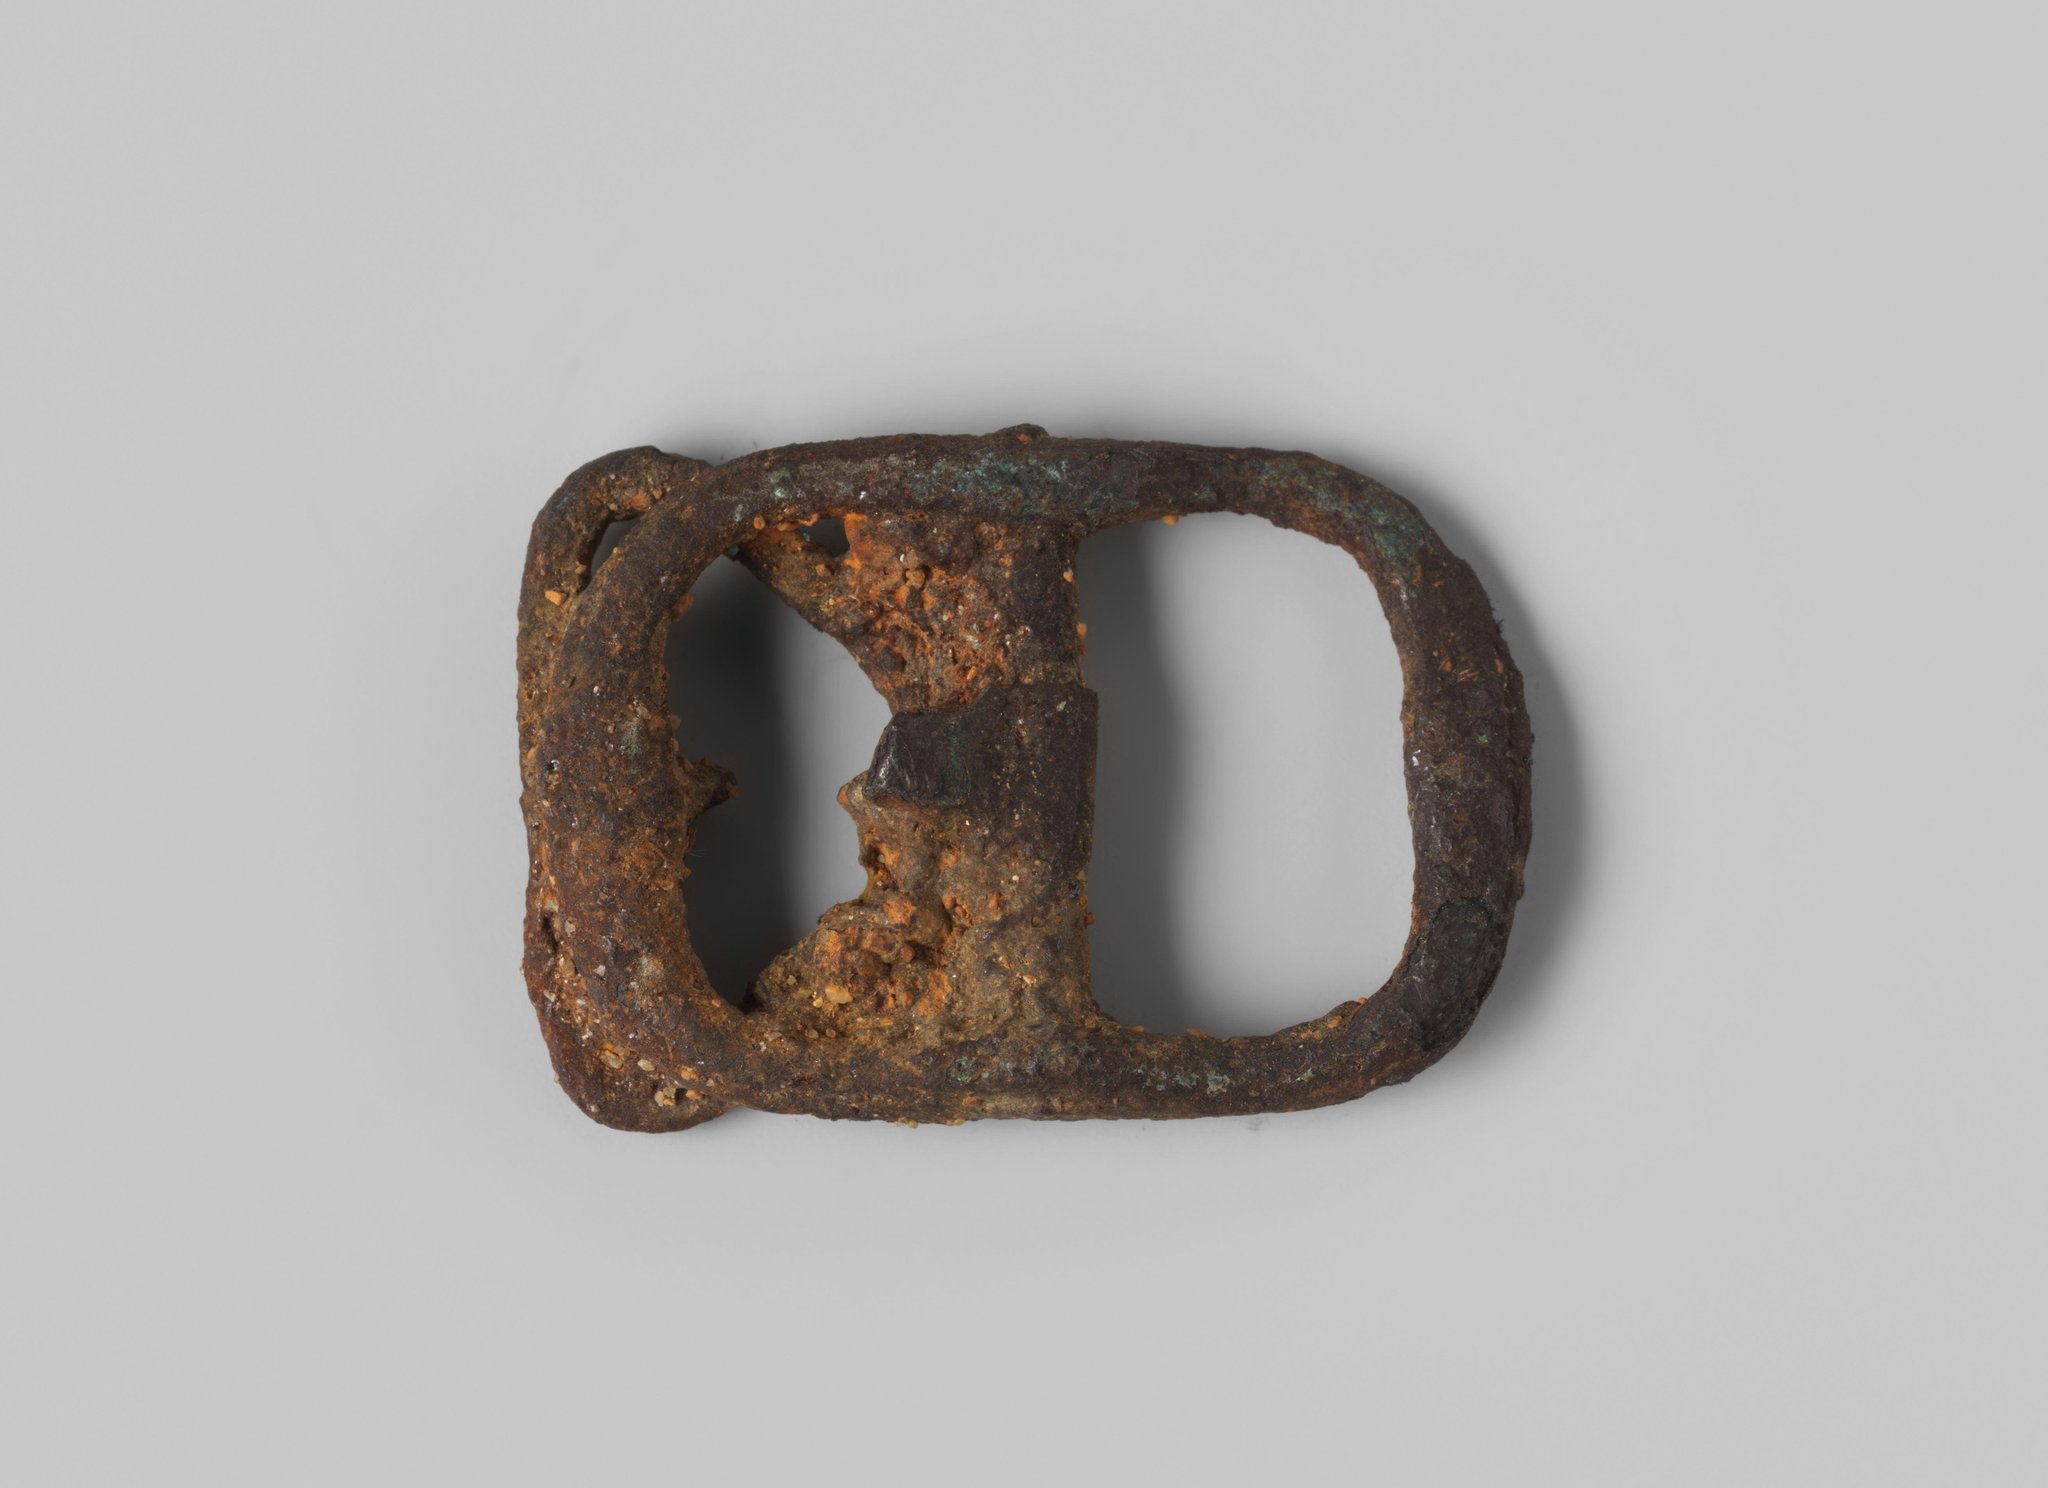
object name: shoe buckle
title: Schoengesp uit het wrak van de Oost-Indiëvaarder Hollandia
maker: Anonymous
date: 1700-1743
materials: copper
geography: netherlands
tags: verenigde oostindische compagnie, hollandia (schip), annet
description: Buckle, chape buckle, shoe buckle; ring, plain, with spindle, tongue broken off, single-pronged loop.